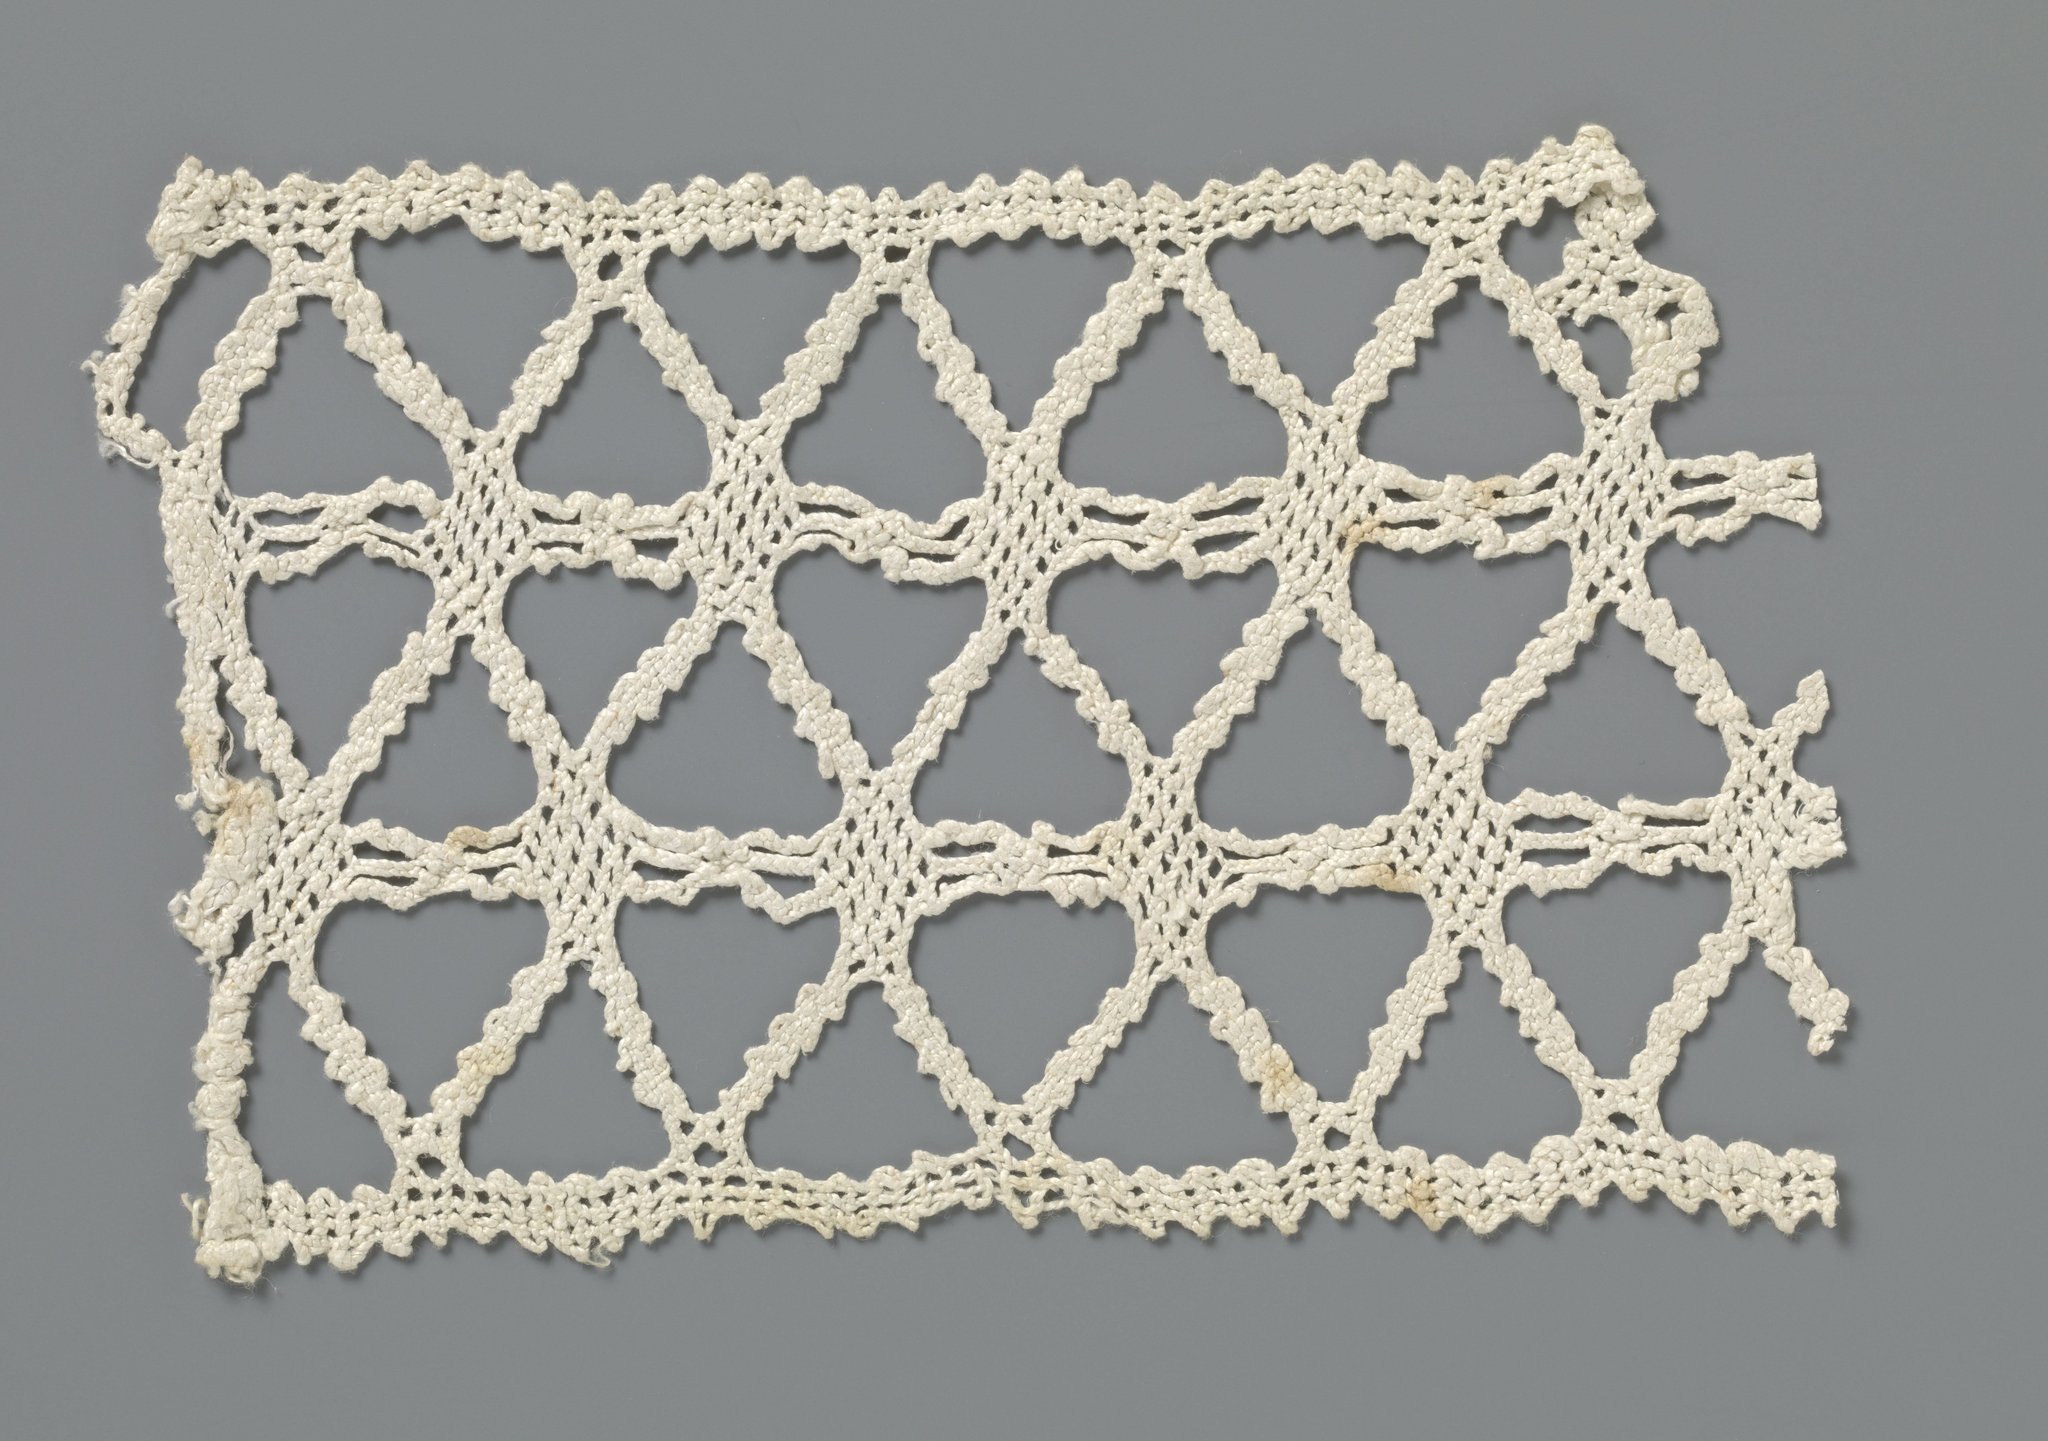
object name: strip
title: Strook kloskant met driehoeken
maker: Anonymous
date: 1850-1899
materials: linen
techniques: lace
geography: germany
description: Strook naturelkleurige kloskant. Er is gewerkt met dikke draden. Het zeer open patroon bestaat uit drie rijen aaneengeschakelde driehoeken. De schuine lijnen van de driehoeken zijn gemaakt van lintjes in dichtgewerkte linnenslag. De horizontale lijnen zijn gemaakt met drie gevlochten lijnen. Op elk hoekpunt zijn de driehoeken met elkaar verbonden door maasgrond, dat hier een min of meer stervormig veldje vormt. Langs de boven- en onderzijde van de strook loopt een randje met vierkante mazen.